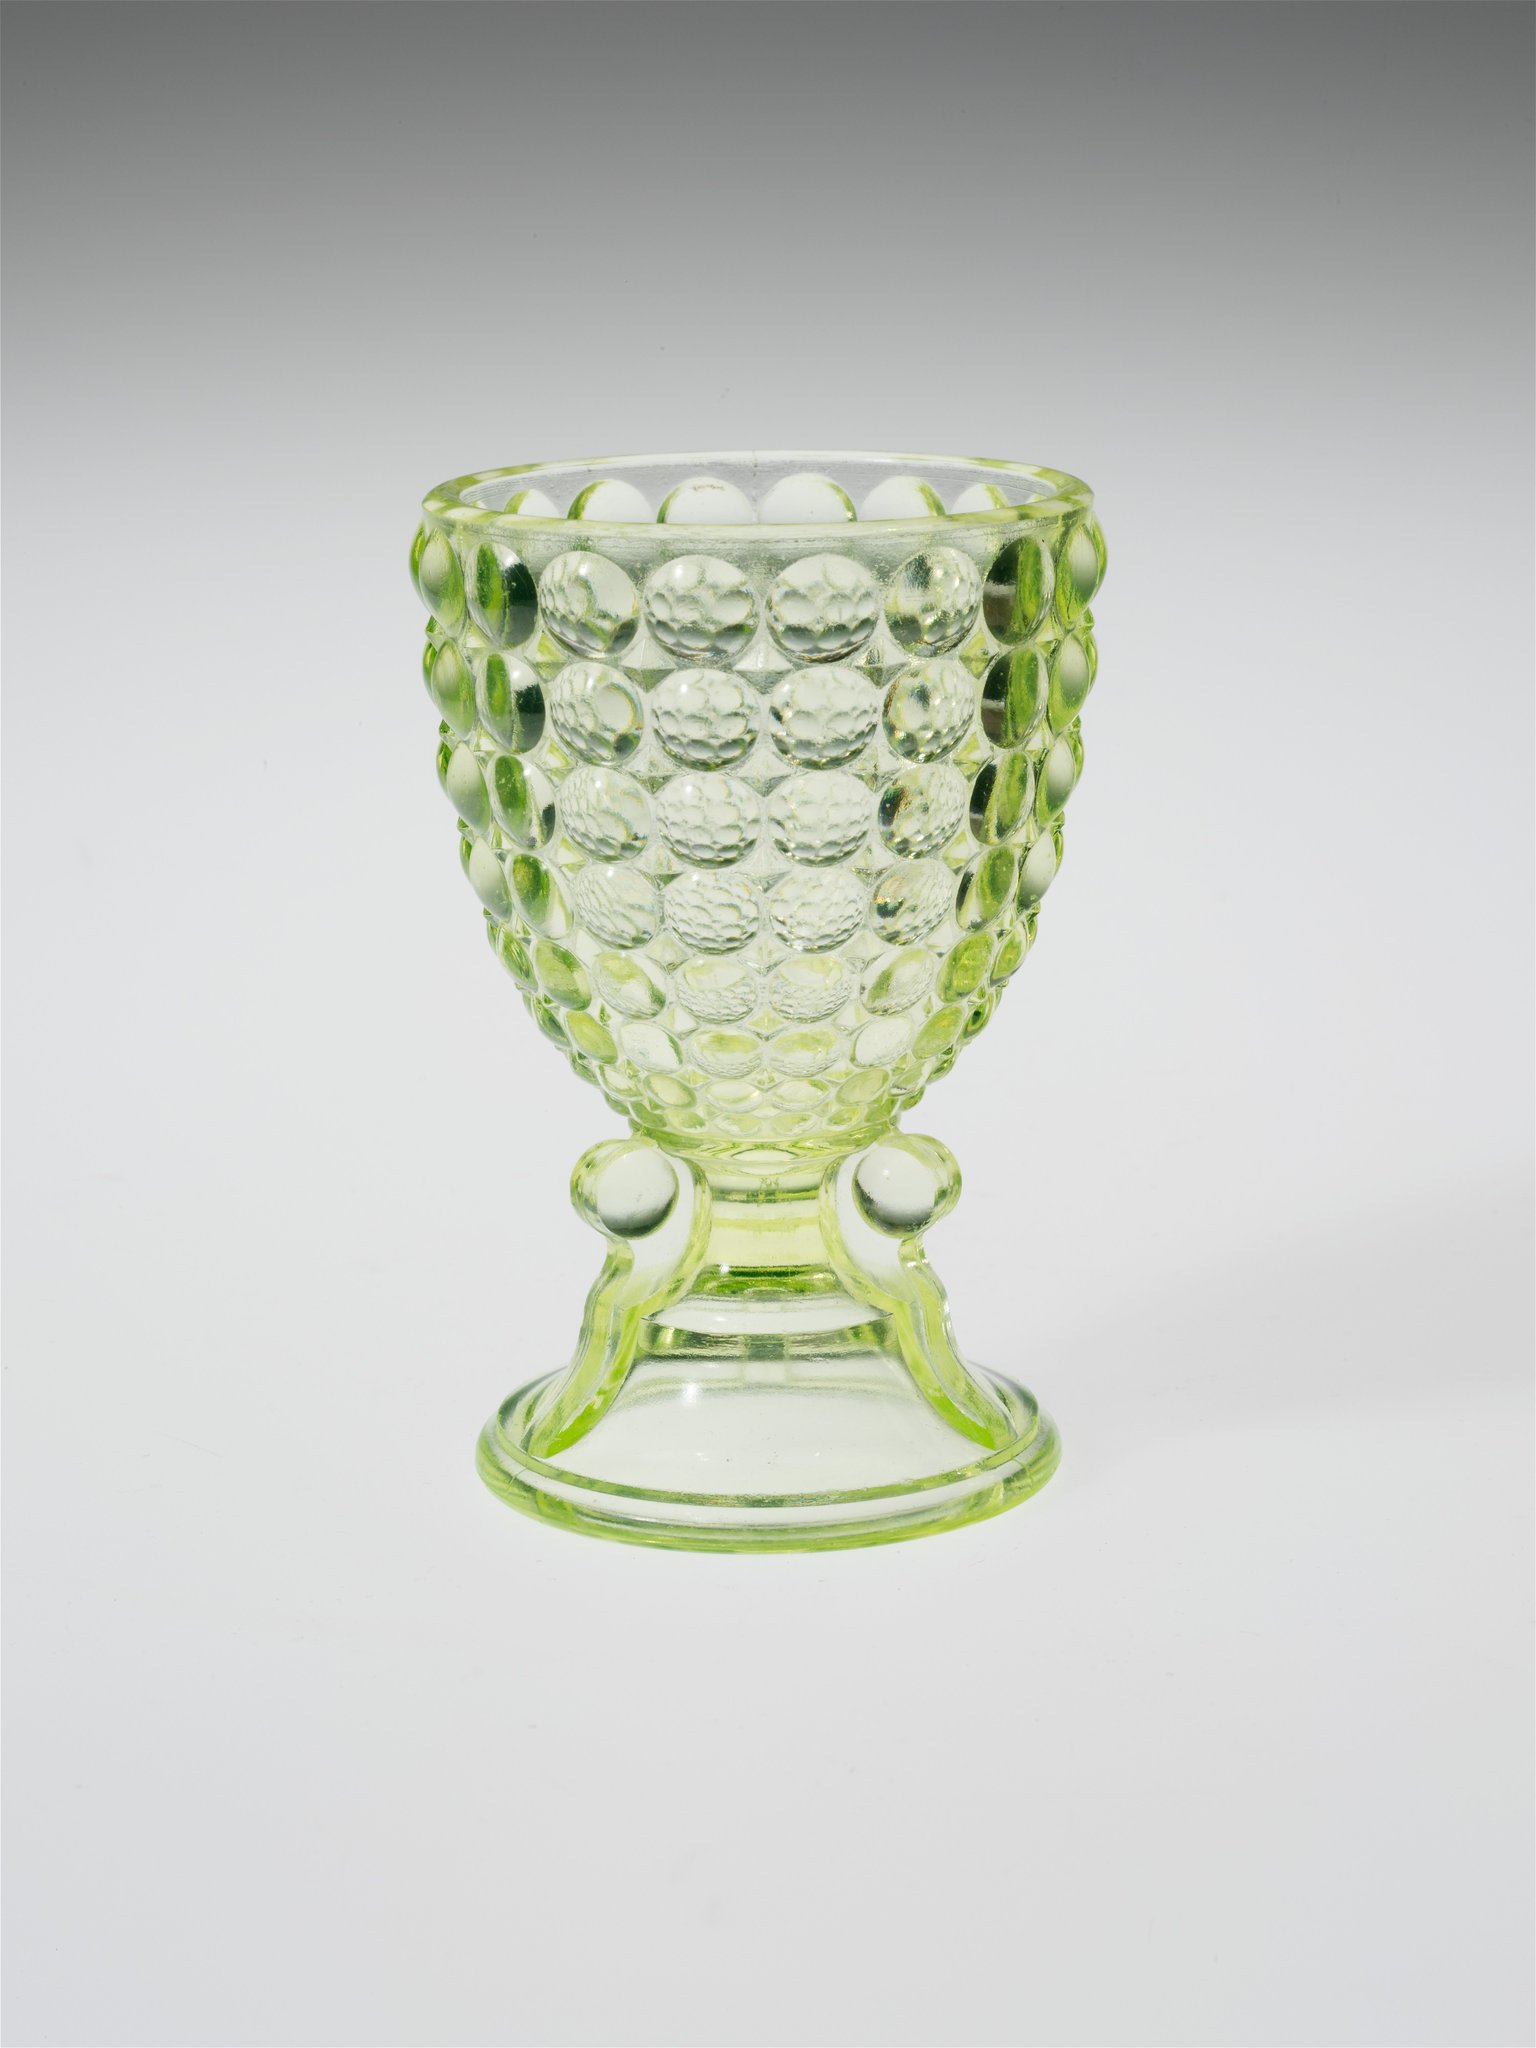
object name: egg cup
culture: american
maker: adams and company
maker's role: maker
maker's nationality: american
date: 1870-1880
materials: glass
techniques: pressed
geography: united states